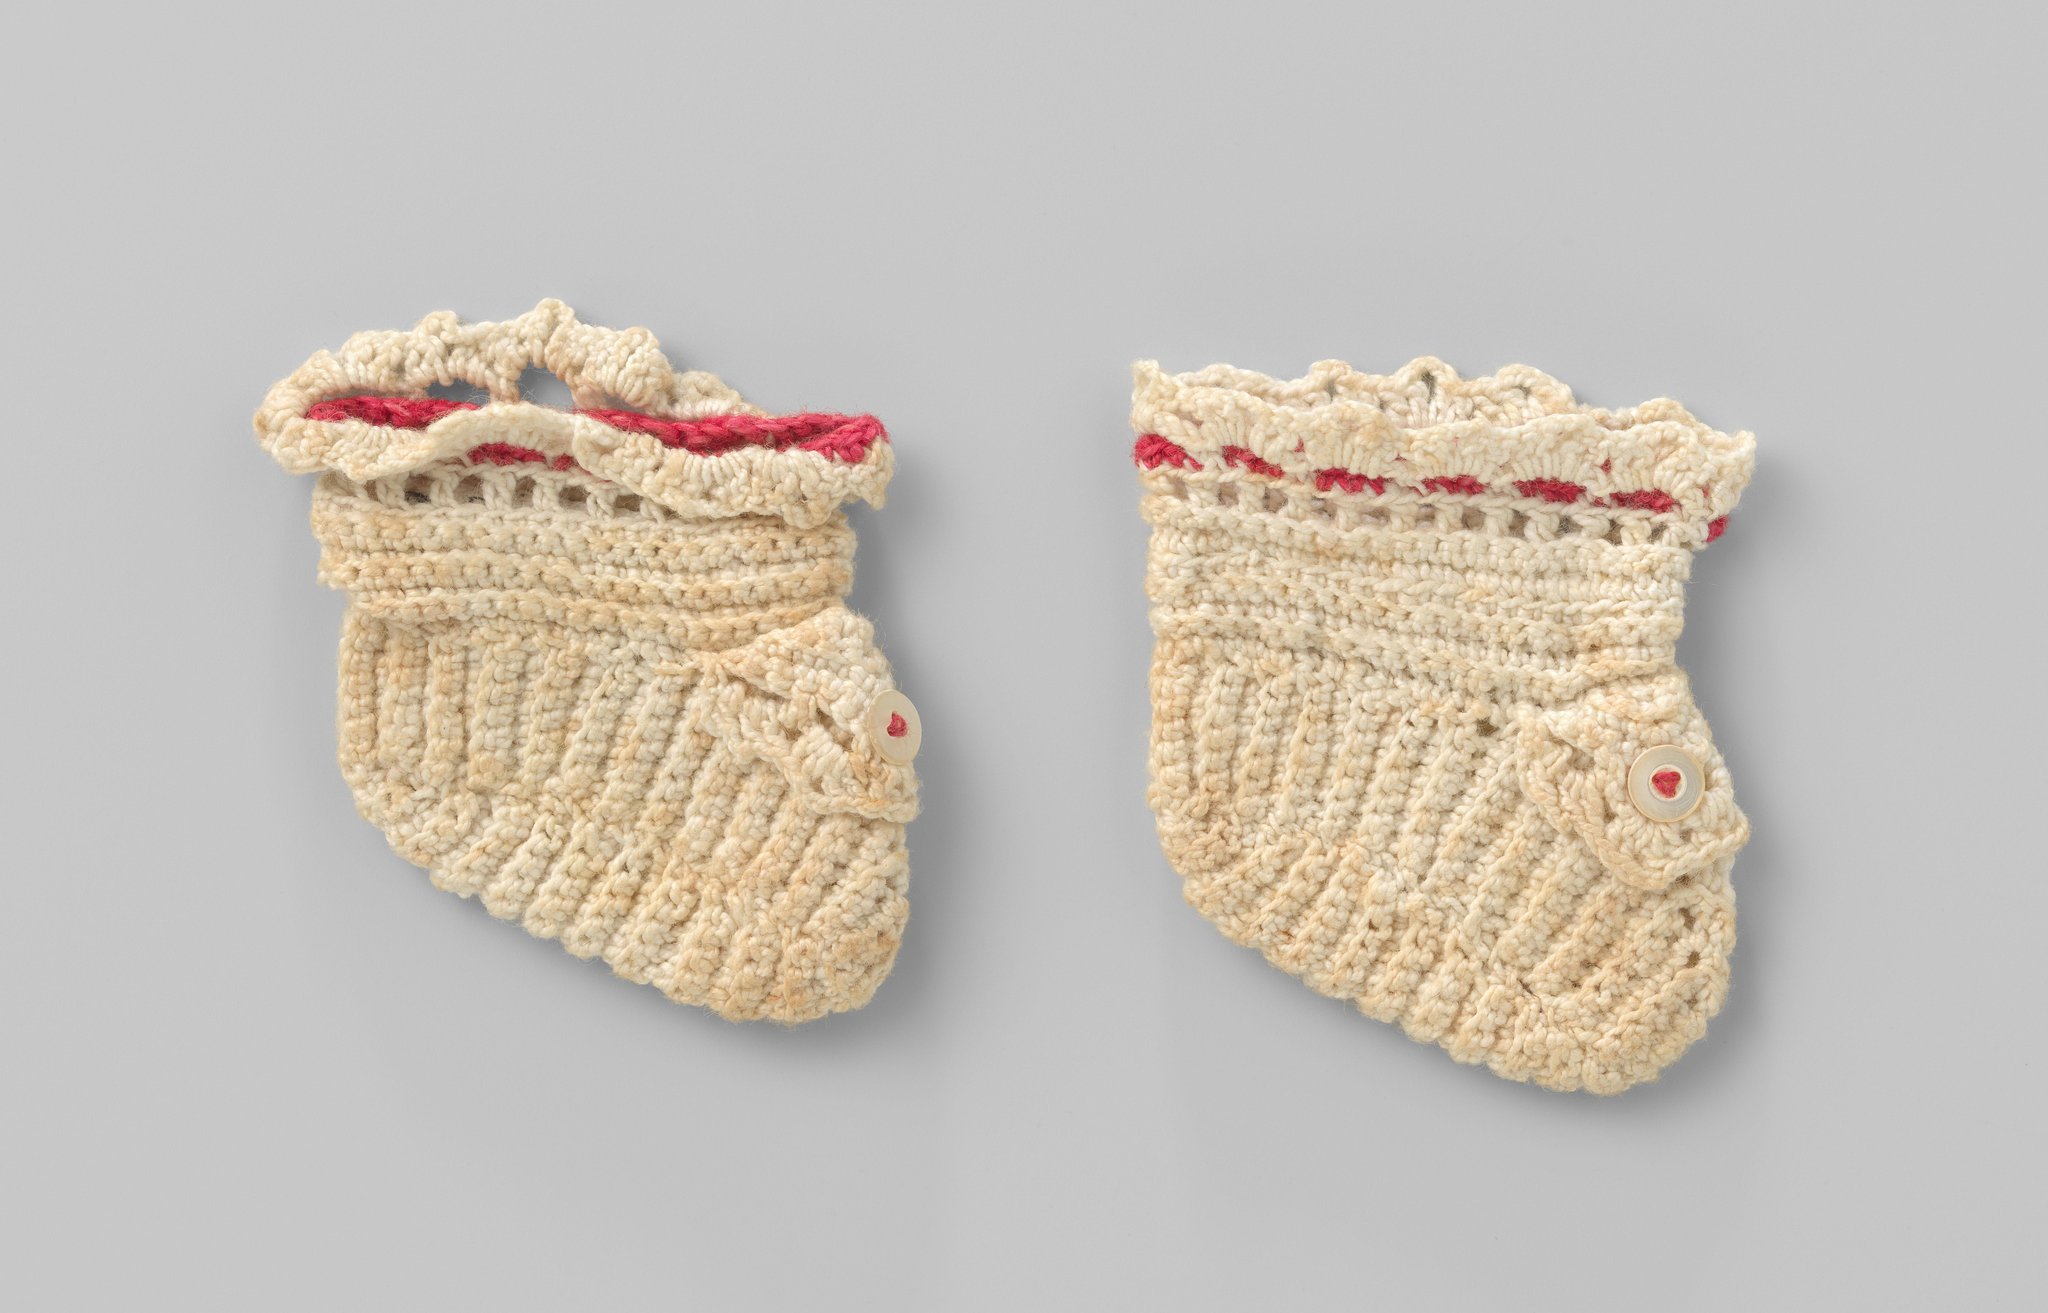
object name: toy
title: Witte gebreide sok met rood koord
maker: Anonymous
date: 1850-1920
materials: textile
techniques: knitting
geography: netherlands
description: Op de wreef een rond parelmoeren knoopje.